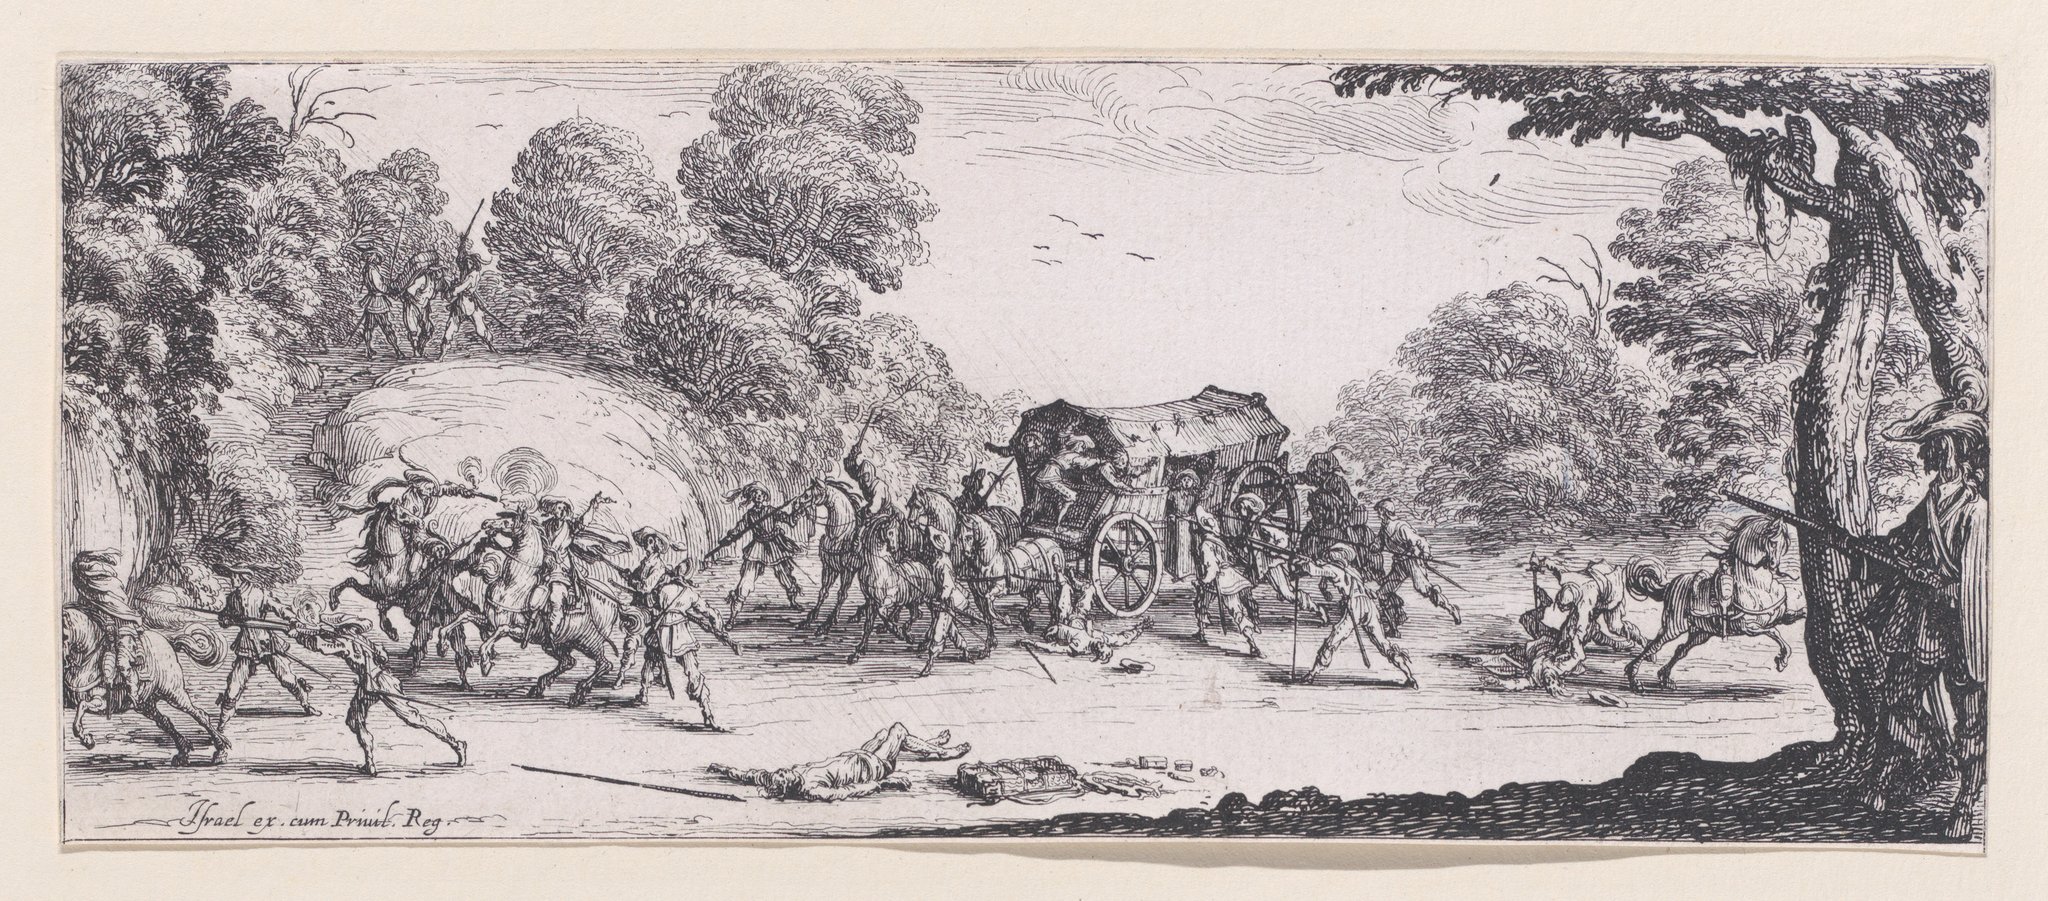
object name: print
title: L'Attaque de la Diligence (The Attack of the Stagecoach), plate 8 from "Les Misères et les Mal-Heures de la Guerre" (The Miseries and Misfortunes of War)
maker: jacques callot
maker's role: artist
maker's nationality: french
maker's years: 1592-1635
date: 1633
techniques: etching